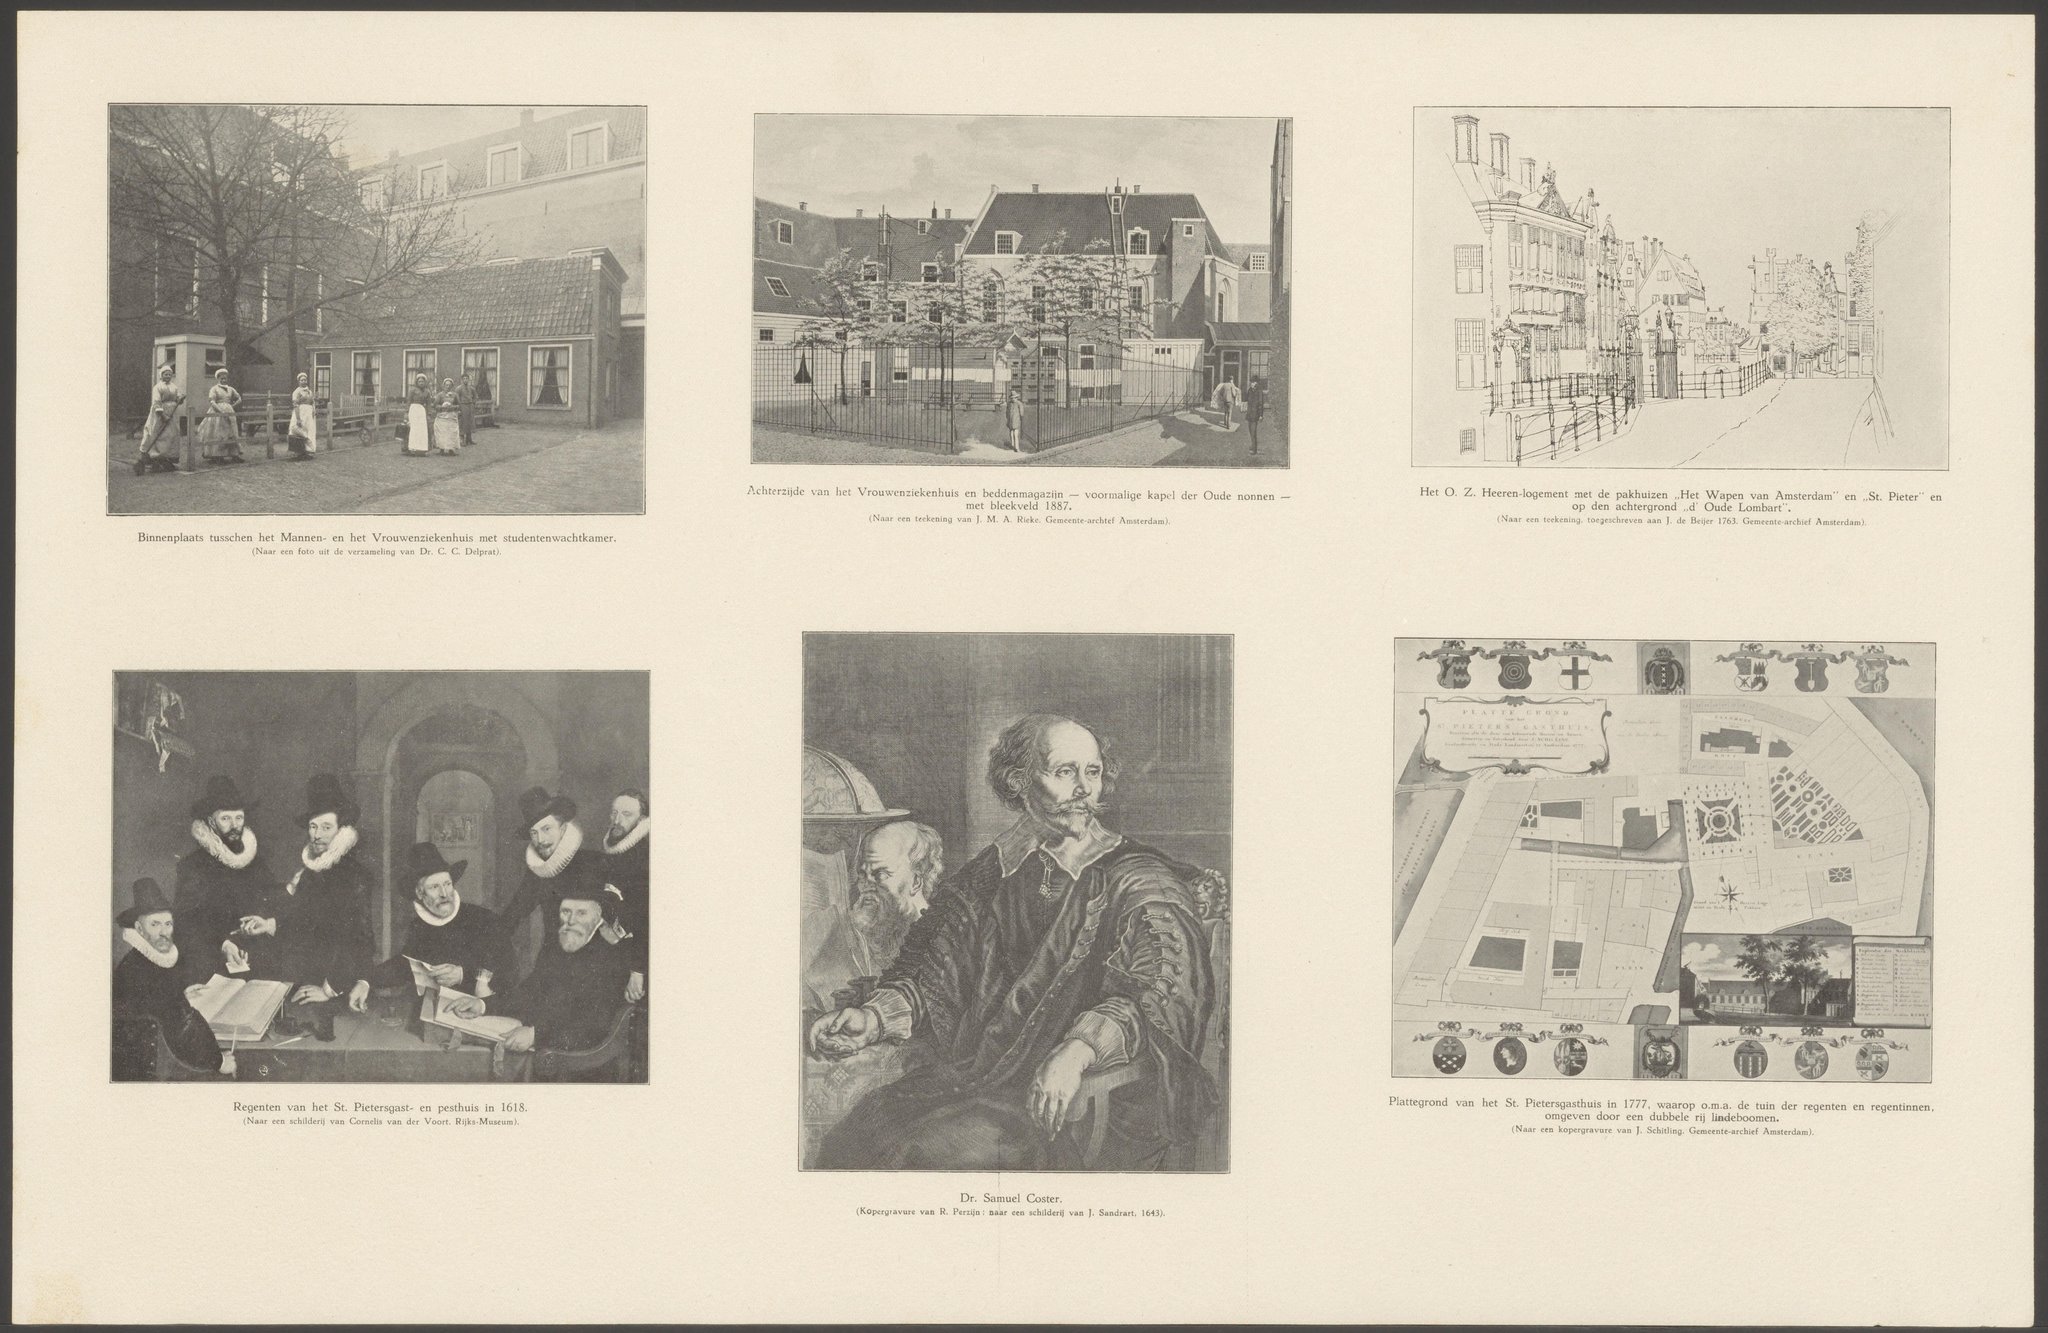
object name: photomechanical print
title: Sint Pieters Gasthuis door de eeuwen heen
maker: Anonymous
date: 1912-1970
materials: paper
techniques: letterpress printing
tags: samuel coster, cornelis geelvink, historical persons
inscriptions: collector's mark: Lugt 1641b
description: Zes losse voorstellingen met gezichten op het Sint Pieters Gasthuis en het Mannen- en vrouwenziekenhuis. Rechtsonder de regenten van het Sint Pieters Gasthuis en een portret van Samuel Coster. Onderwerpsrubriek binnen de Atlas Amsterdam: Armwezen en liefdadige instellingen: I. Stadsinrichtingen: Binnengasthuis.